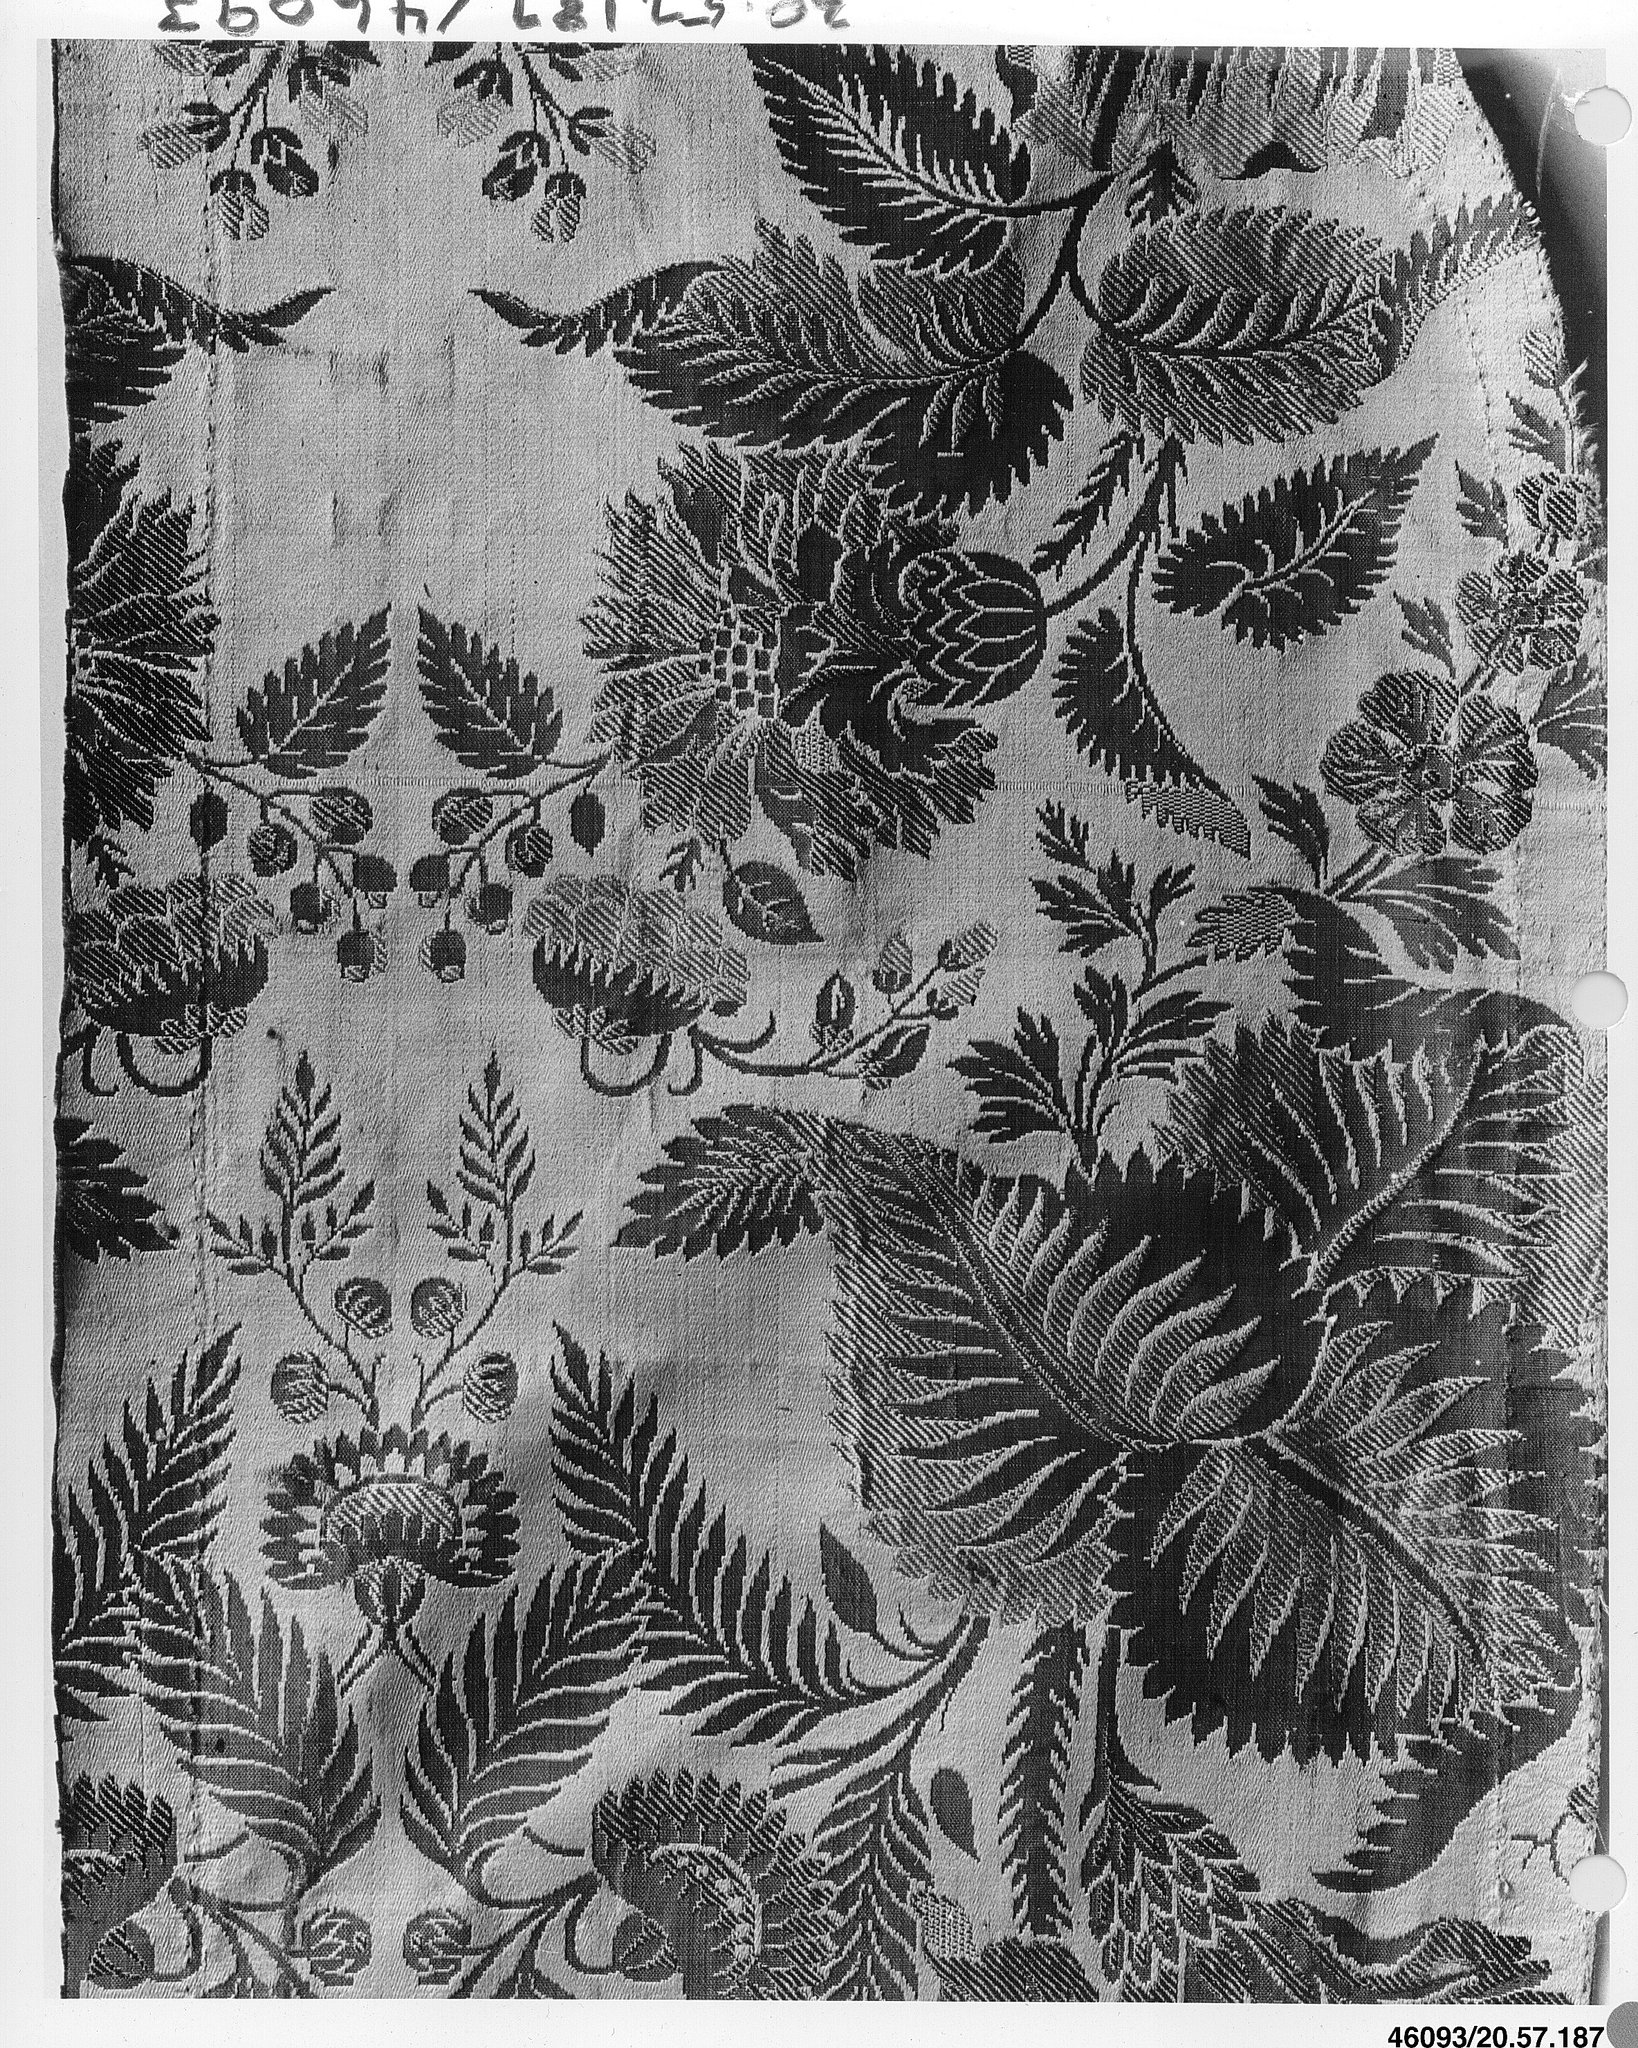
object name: piece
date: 1730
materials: silk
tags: flowers,leaves